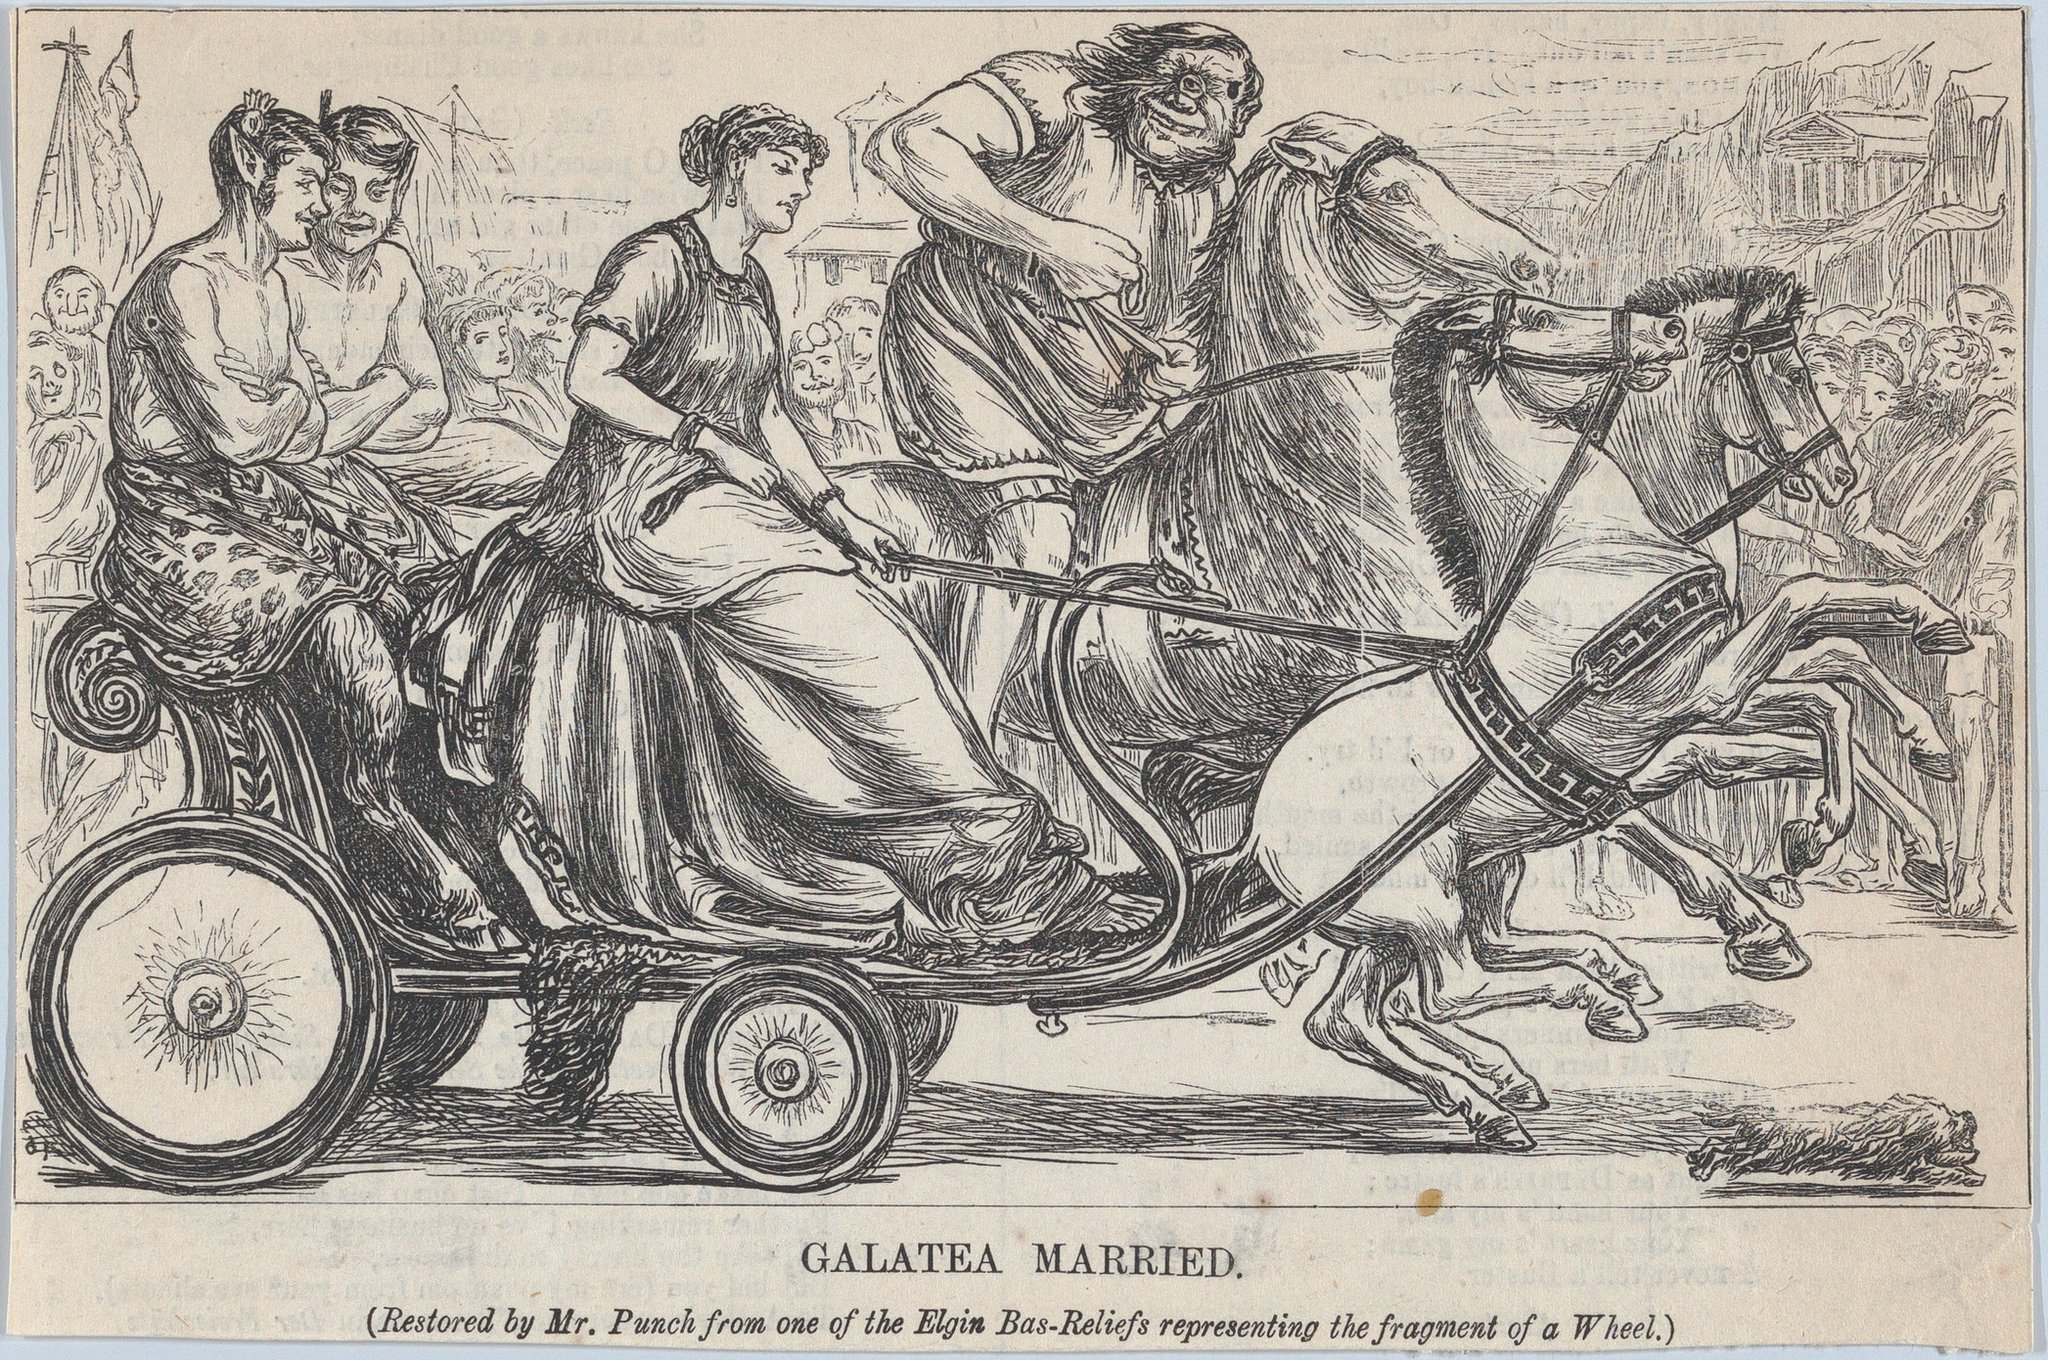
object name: print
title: Galatea Married – Restored by Mr. Punch from one of the Elgin Bas-Reliefs representing the fragment of a Wheel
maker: anonymous, british, 19th century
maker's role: artist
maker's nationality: british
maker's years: 1800-1900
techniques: engraving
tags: galatea,fauns,horses,chariots